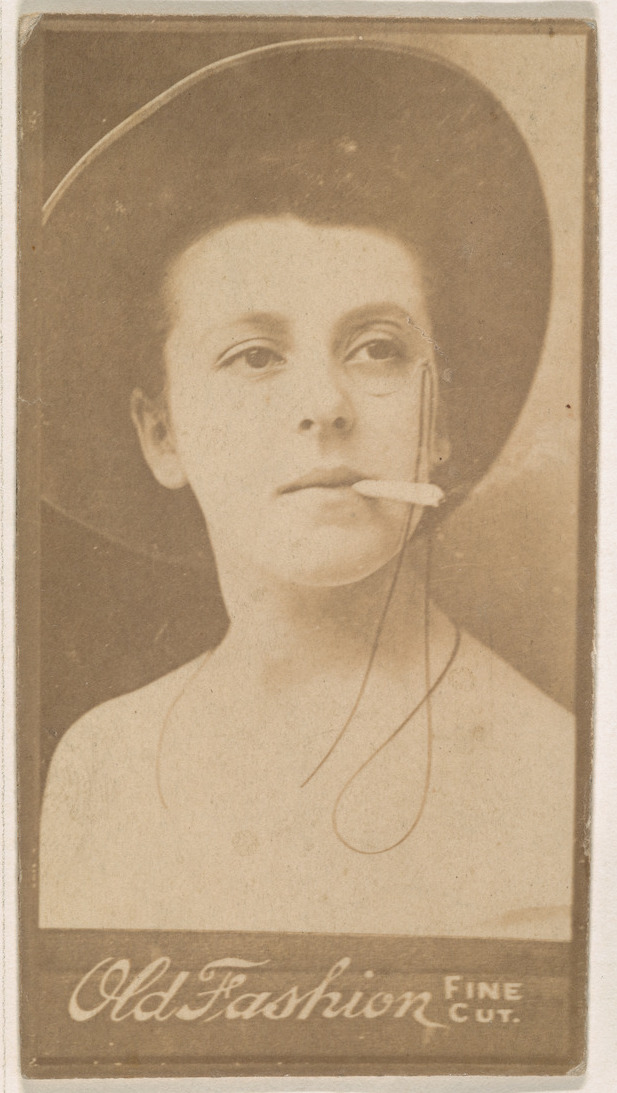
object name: photograph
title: Actress with monocle and cigarette, from the Actresses series (N664) promoting Old Fashion Fine Cut Tobacco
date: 1888-1890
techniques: albumen silver print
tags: portraits,women,smoking,actresses